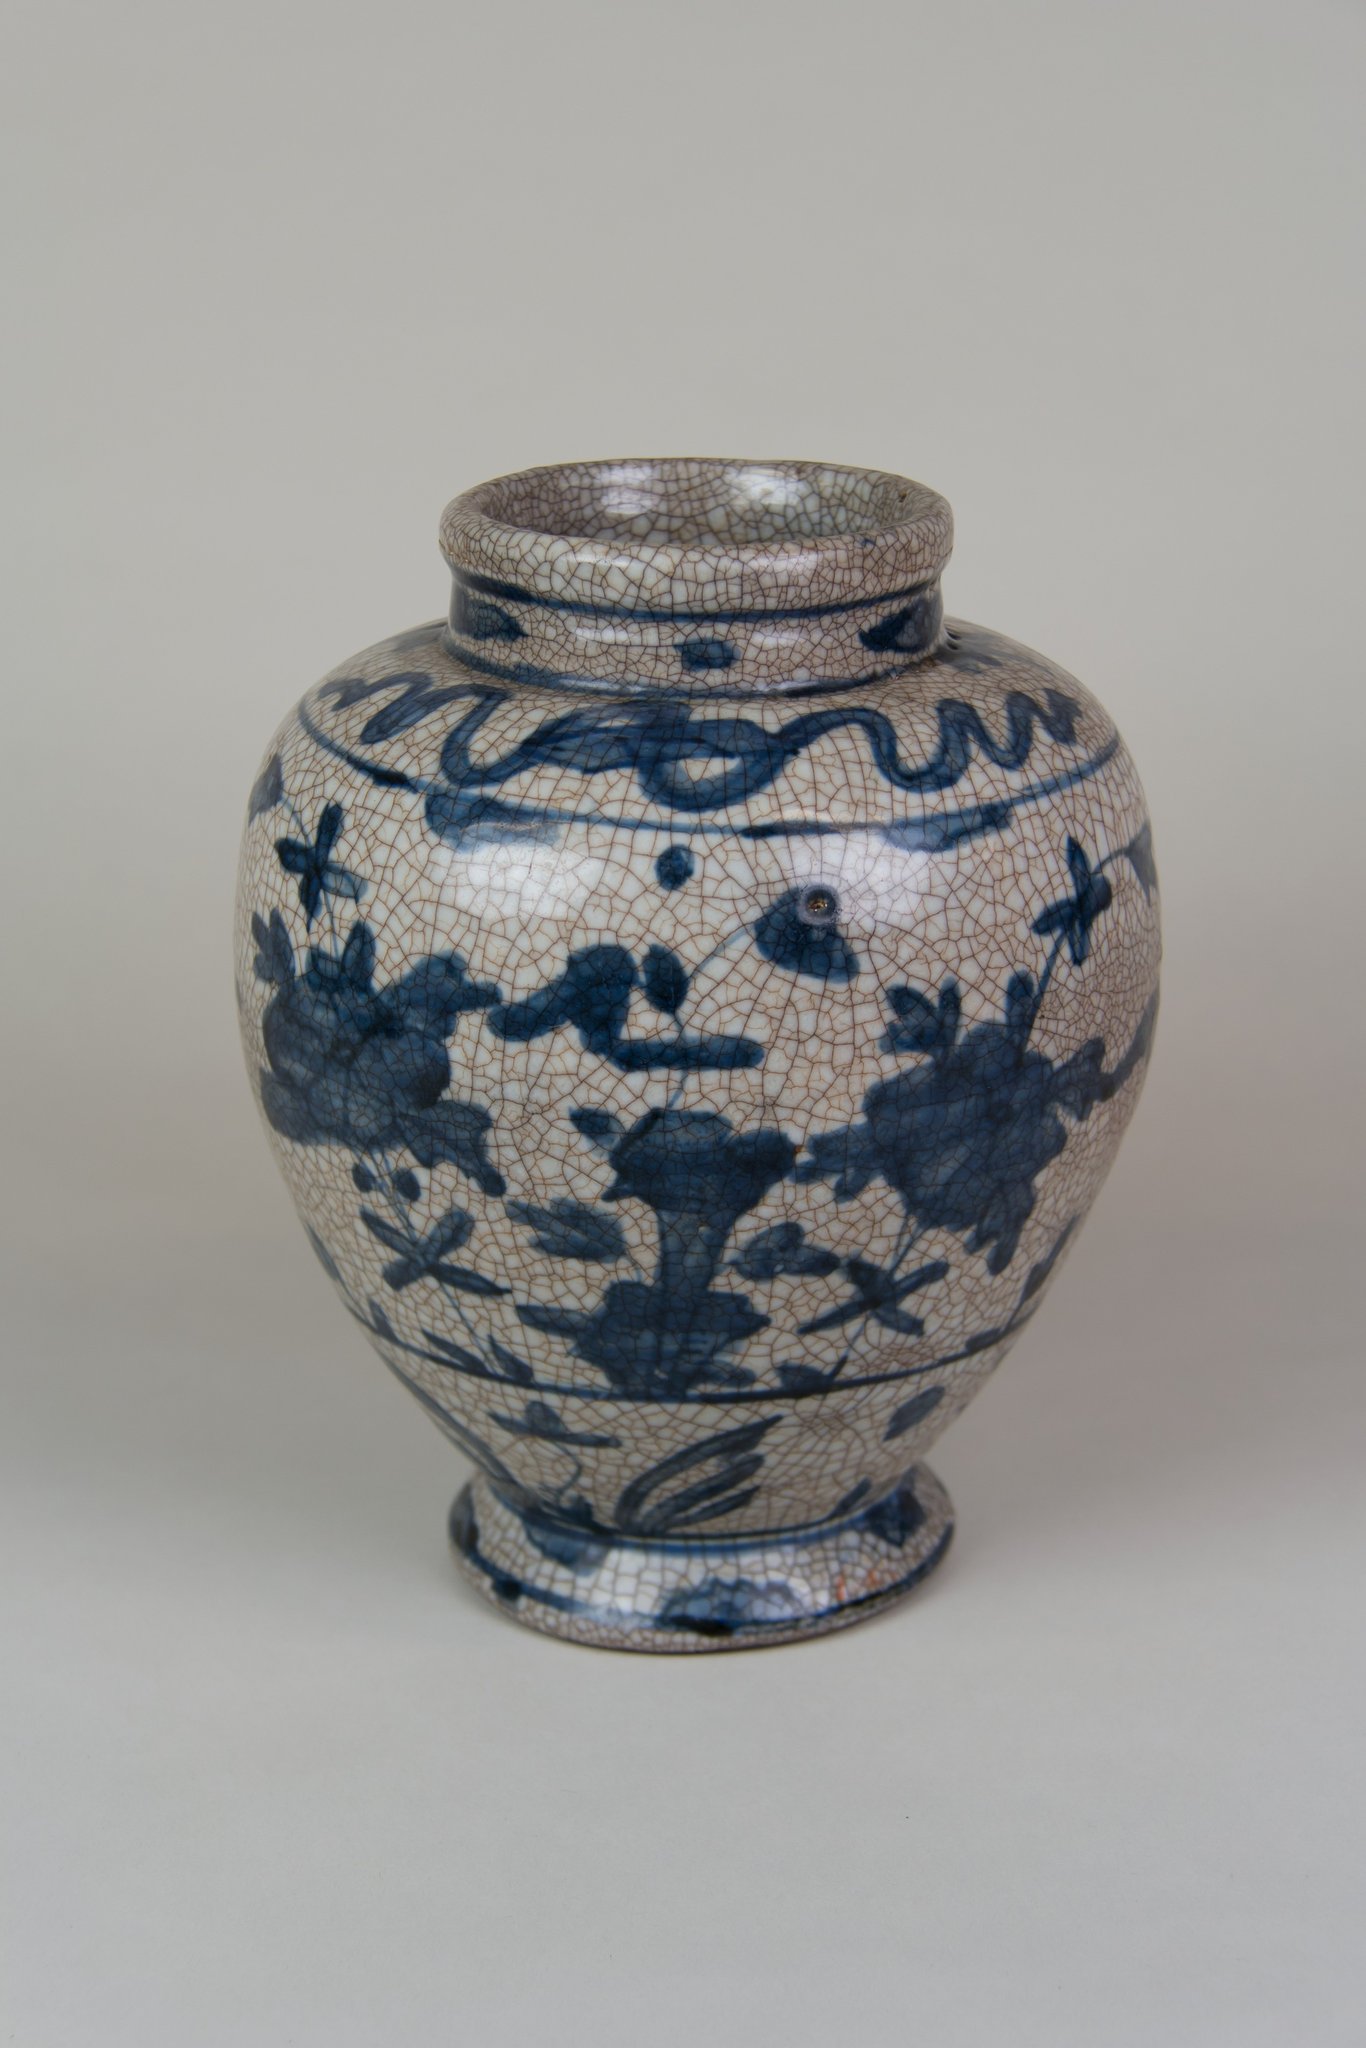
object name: jar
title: Jar with flowers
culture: chinese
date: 1567-1633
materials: cobalt, porcelain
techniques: painting, underglaze